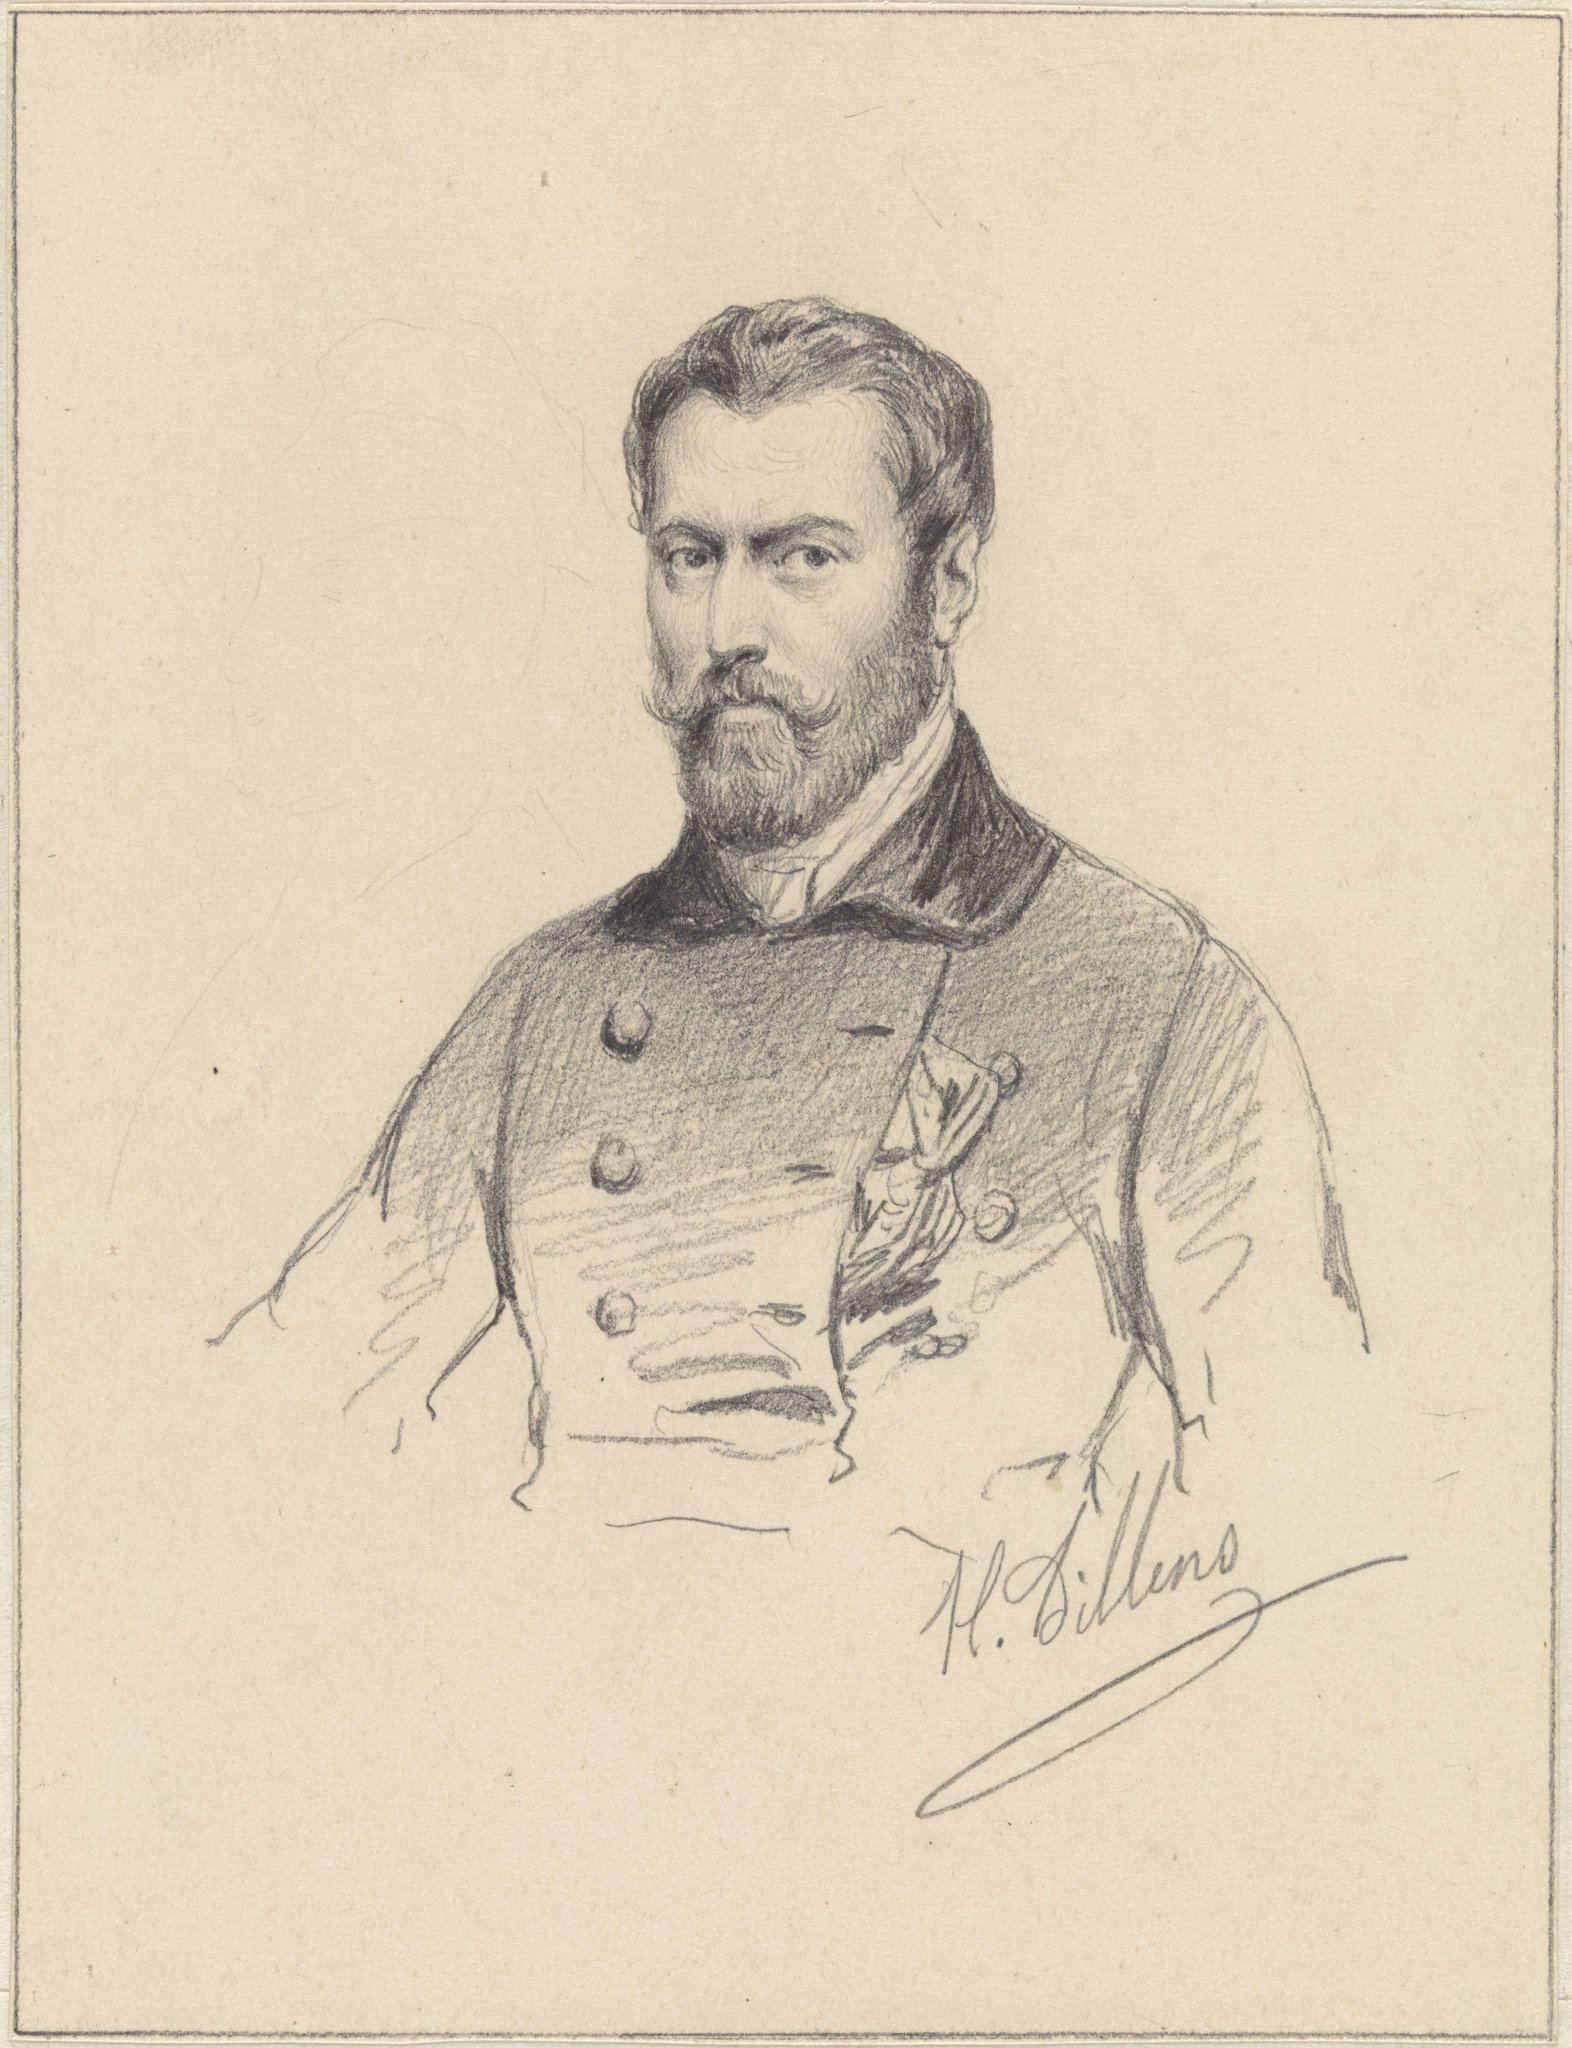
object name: design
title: Zelfportret van Hendri Dillens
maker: henri dillens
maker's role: draughtsman, painter, print maker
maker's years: 1812-1872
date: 1841-1842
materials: paper, pencil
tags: ghent, brussels, painter, print maker, draughtsman, henri dillens, historical persons, portrait, self-portrait of painter, portrait, self-portrait of artist, portrait, self-portrait of draughtsman